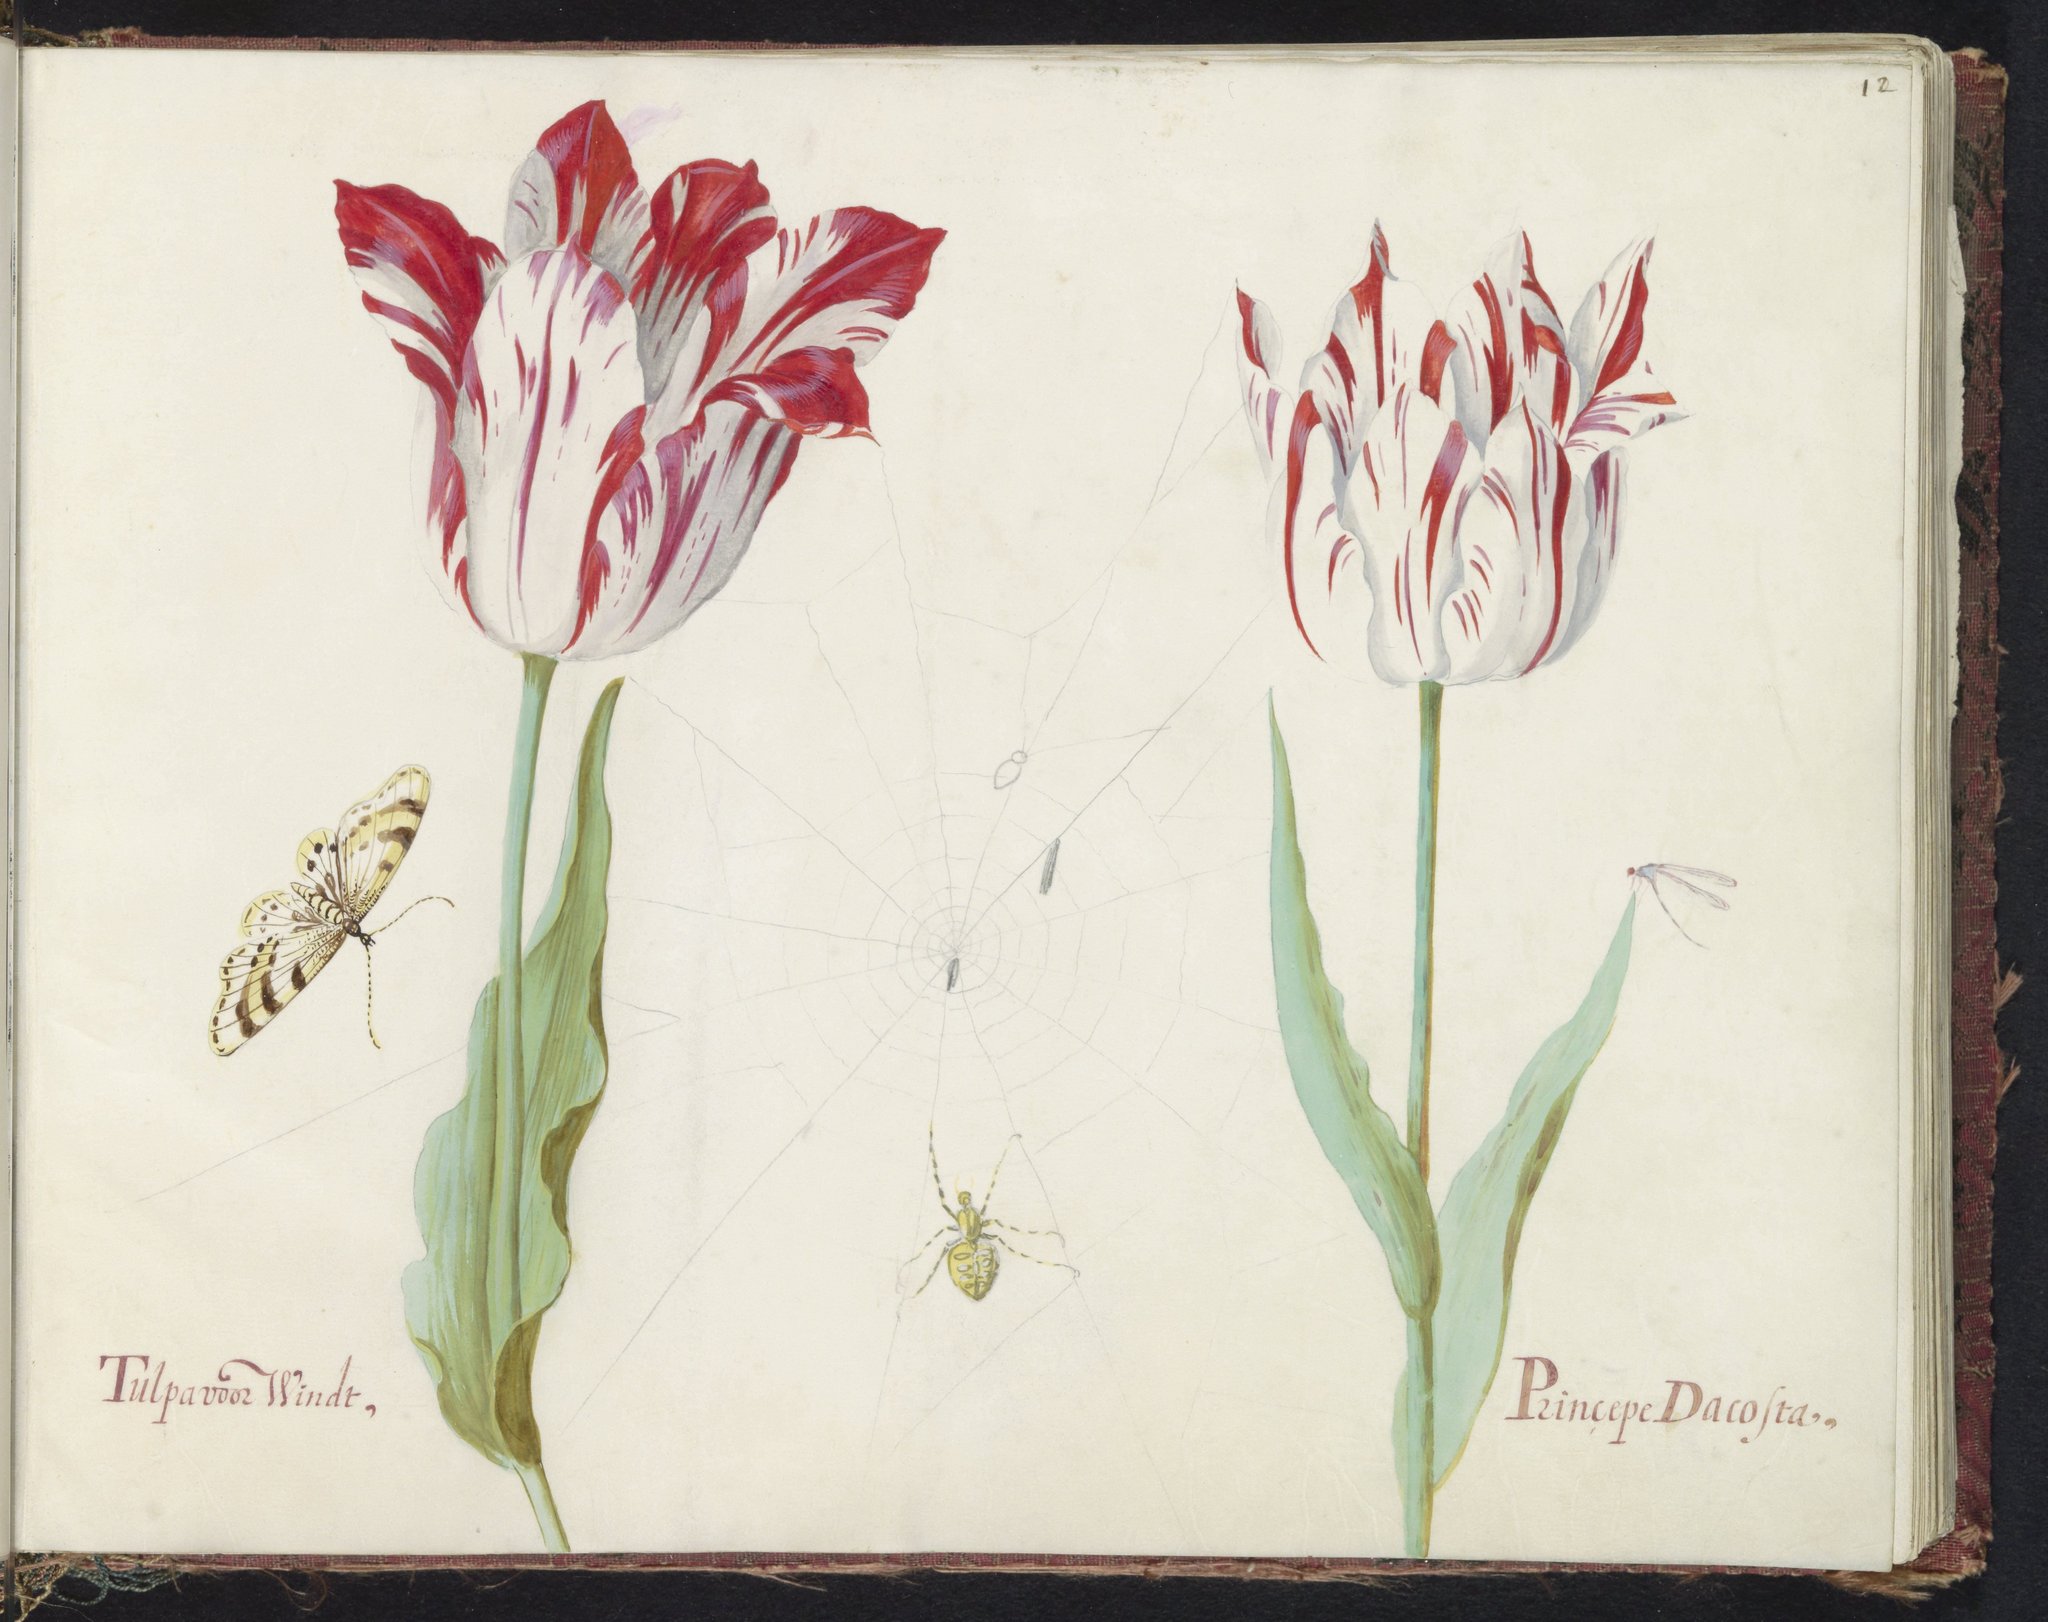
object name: drawing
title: Tulpa voor Windt / Princepe Dacosta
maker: jacob marrel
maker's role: draughtsman, painter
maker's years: 1614-1681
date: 1637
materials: paint, parchment, pencil, watercolor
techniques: brush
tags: spiders, insects: butterfly, flowers: tulip, insects: fly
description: De tekening maakt deel uit van een album.